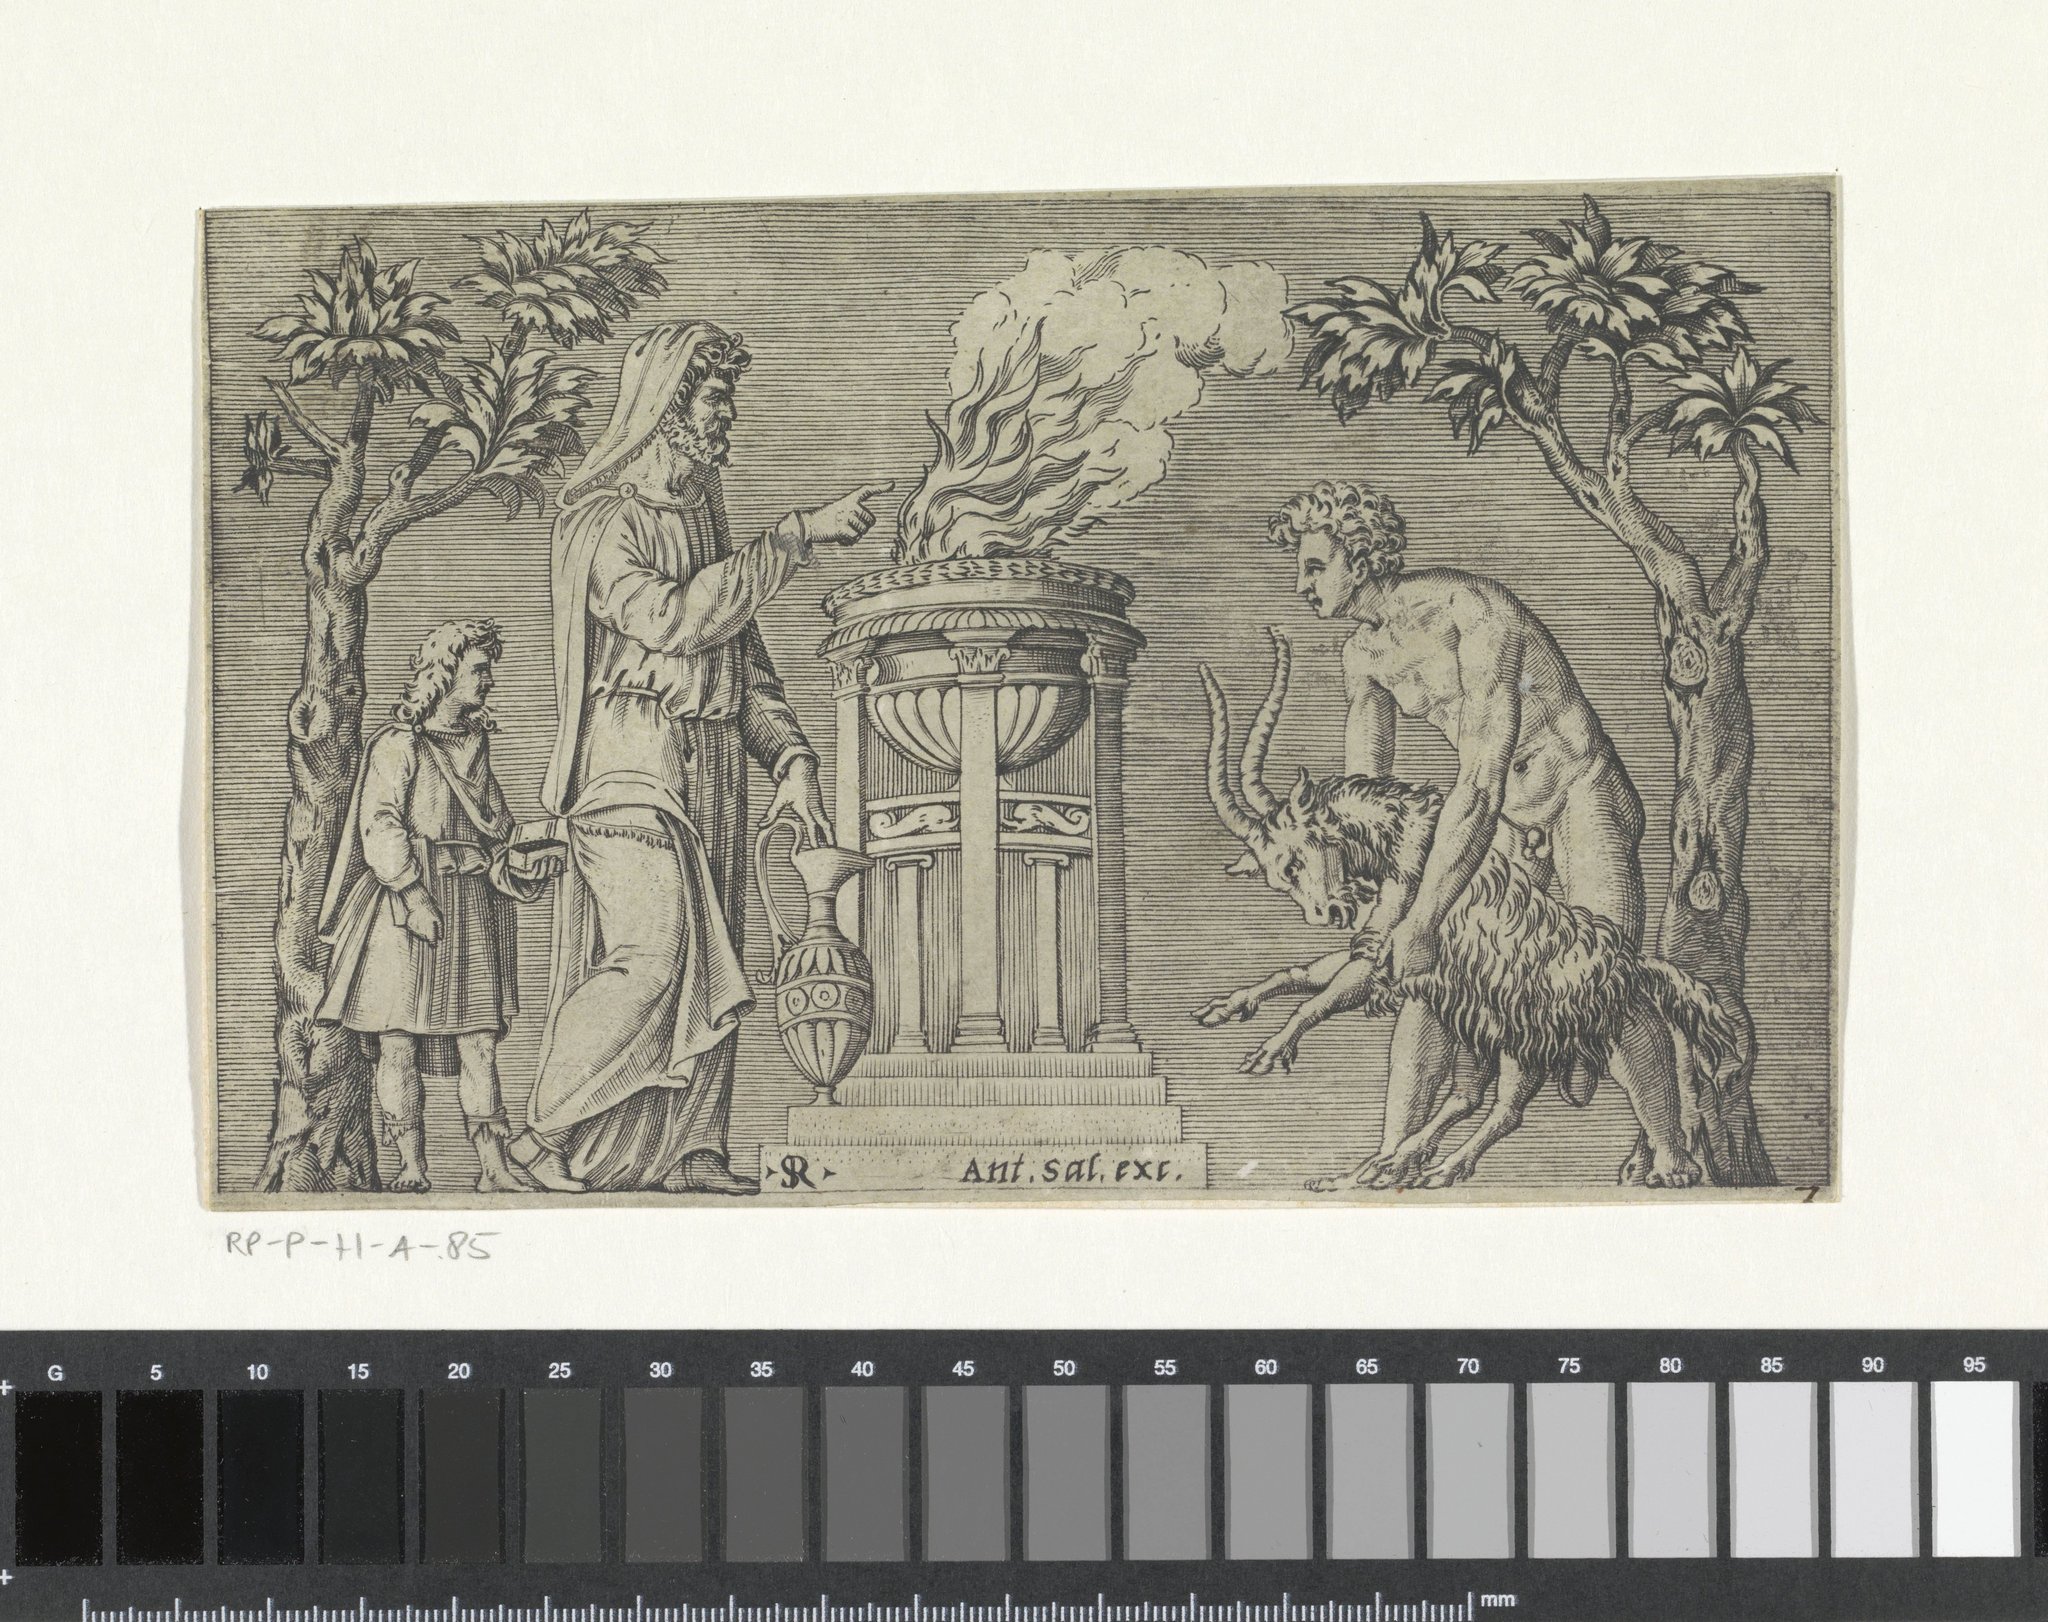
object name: print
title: Antieke reliëfs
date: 1517-1562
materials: paper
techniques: engraving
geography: rome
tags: animal sacrifice ~ roman religion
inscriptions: collector's mark: Lugt 10, collector's mark: Lugt 11, number: ‘7’, collector's mark: ‘Hinloopen’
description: Een priester en een jonge assistent staan links van een altaar met daarop een brandend vuur. Rechts een naakte figuur met een ram om te offeren.